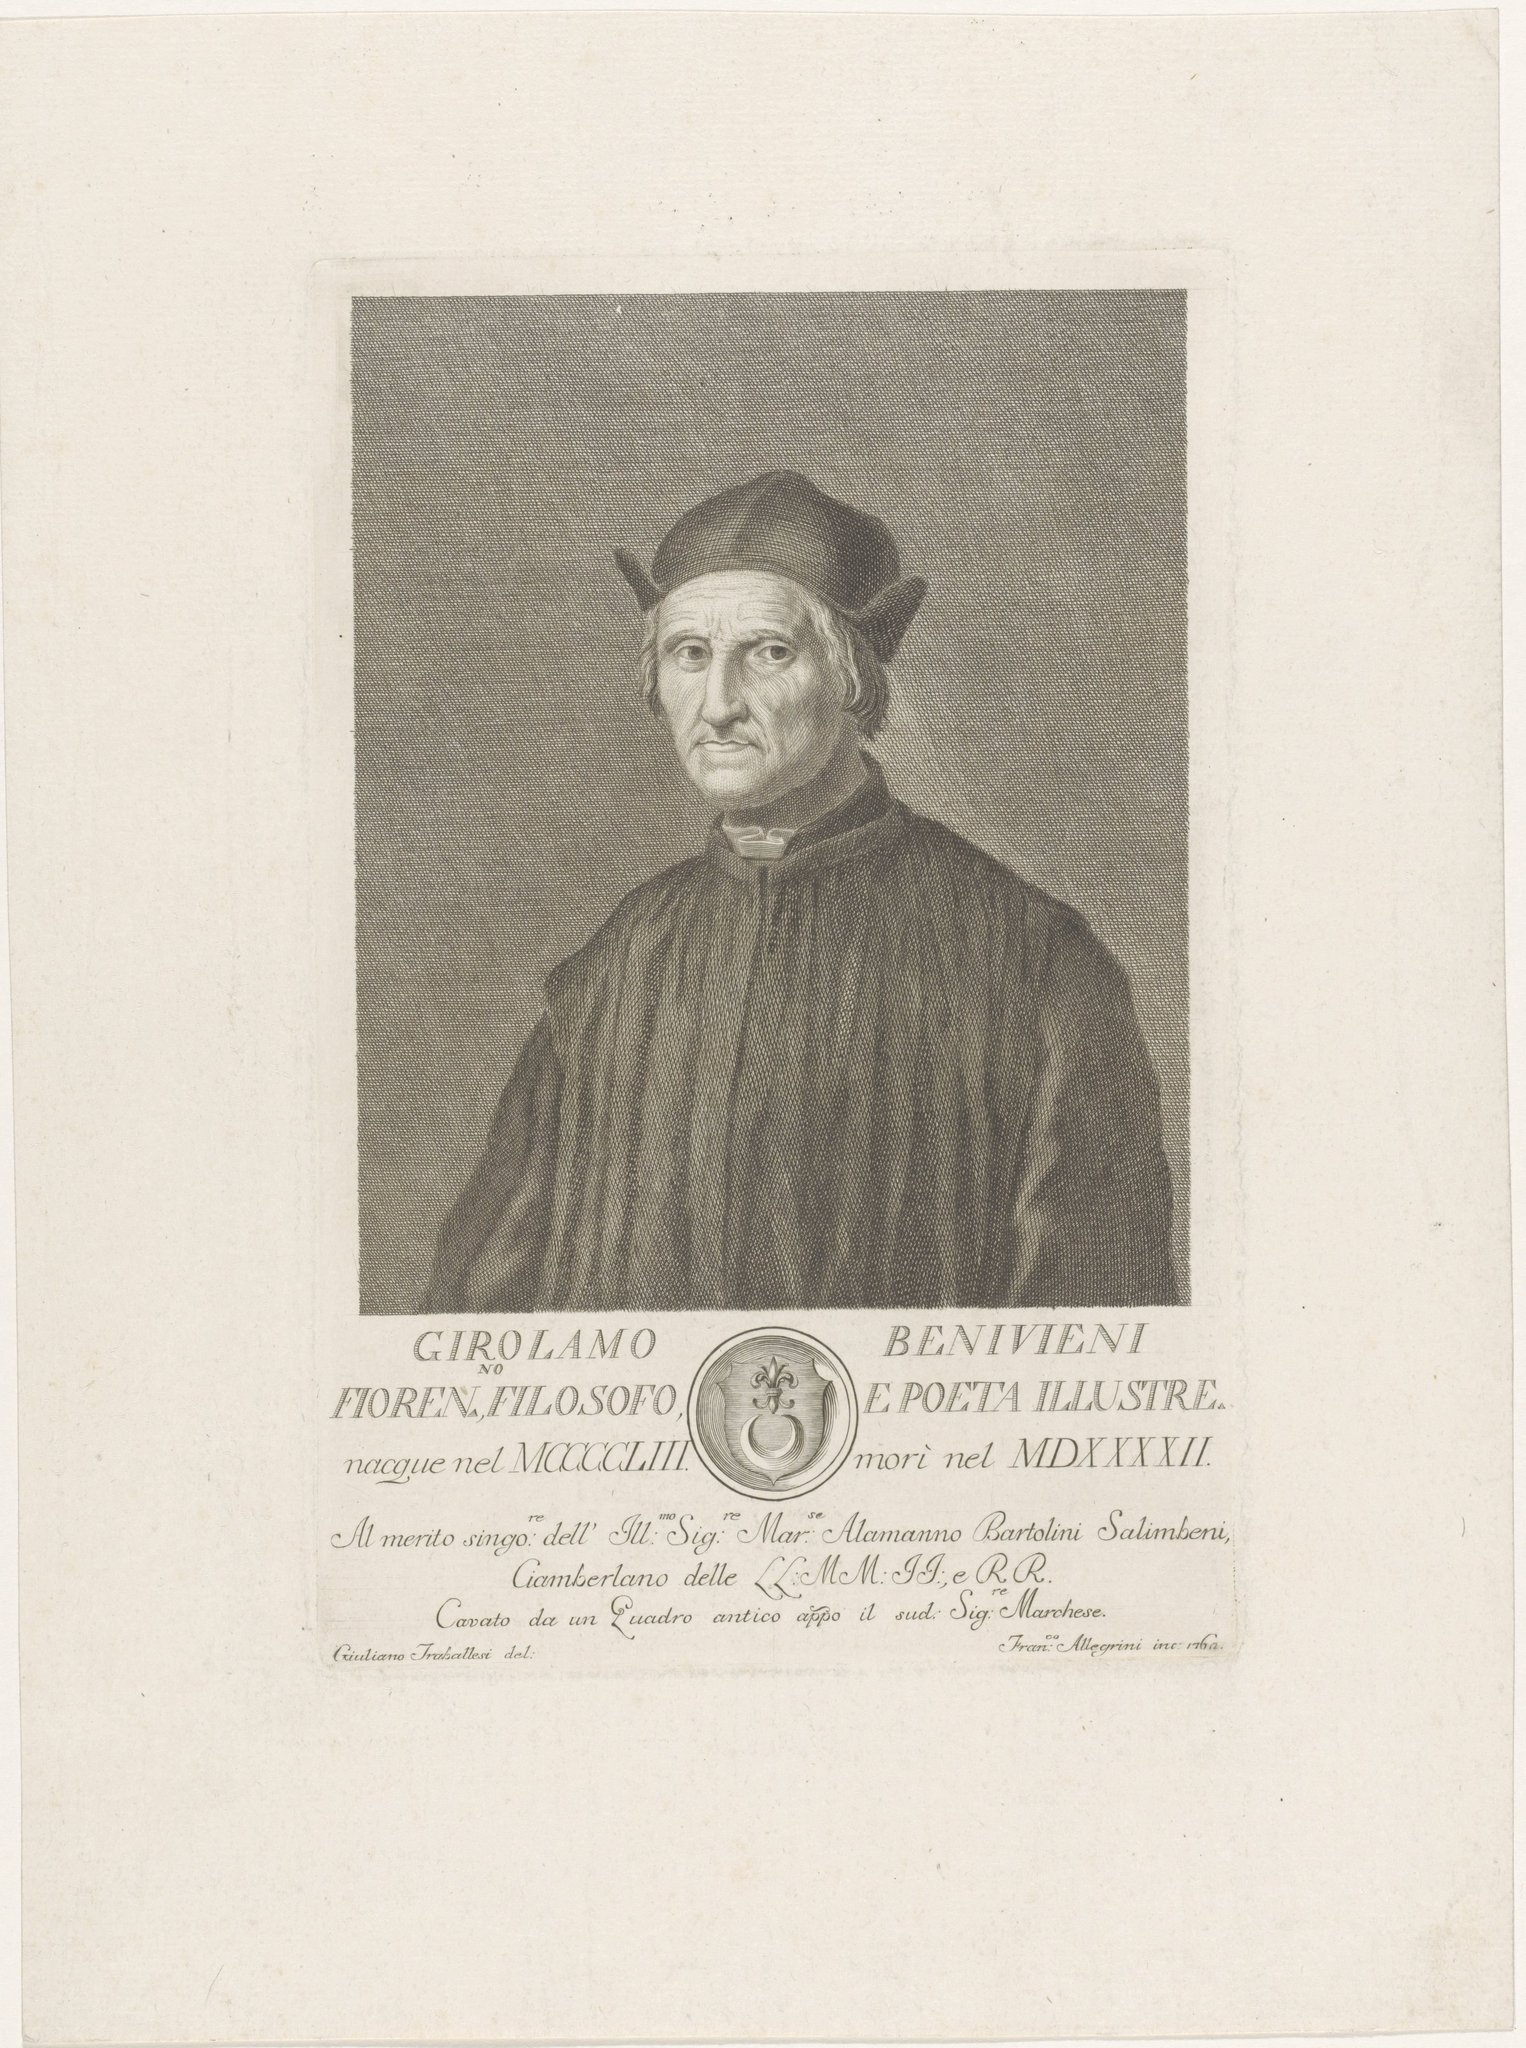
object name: print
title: Portret van Girolamo Benivieni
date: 1762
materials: paper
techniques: engraving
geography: florence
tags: historical persons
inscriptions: collector's mark: Lugt 2228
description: Portret van filosoof en dichter Girolamo Benivieni. Onder het portret een tekst in het Italiaans en een wapenschild in een cirkelvormig kader.